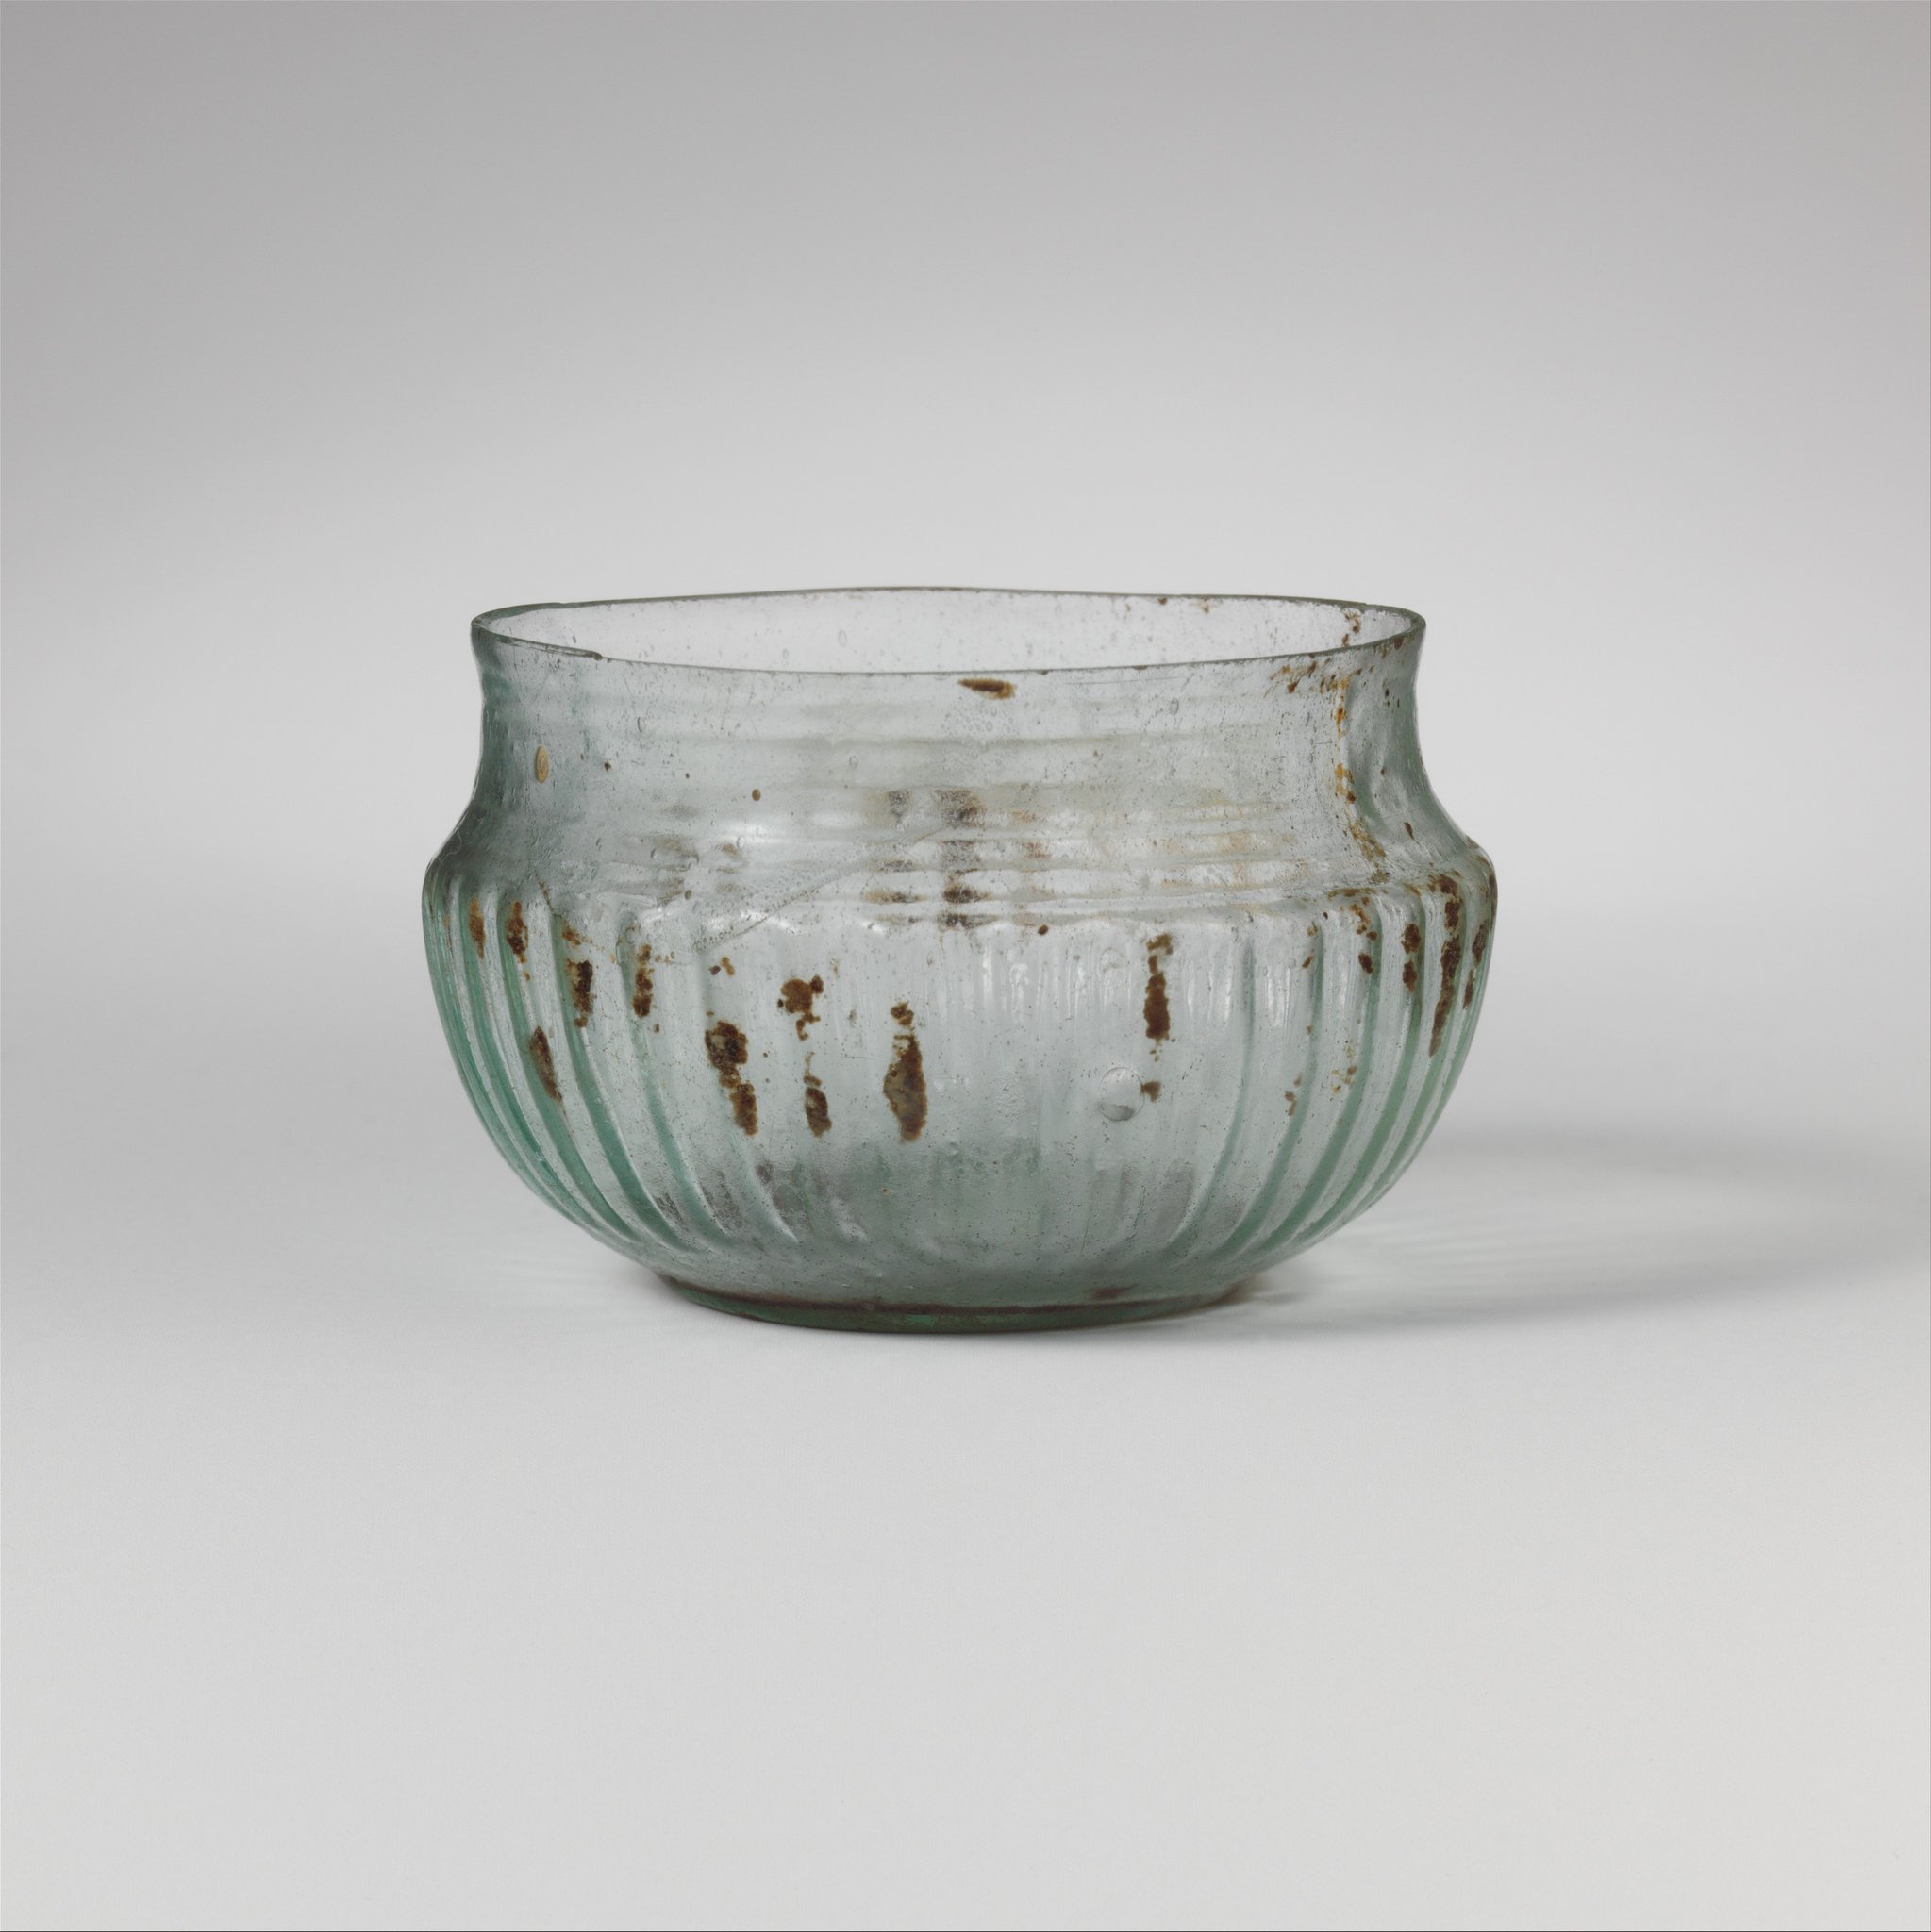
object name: bowl, ribbed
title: Glass ribbed bowl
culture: roman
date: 1-100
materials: glass